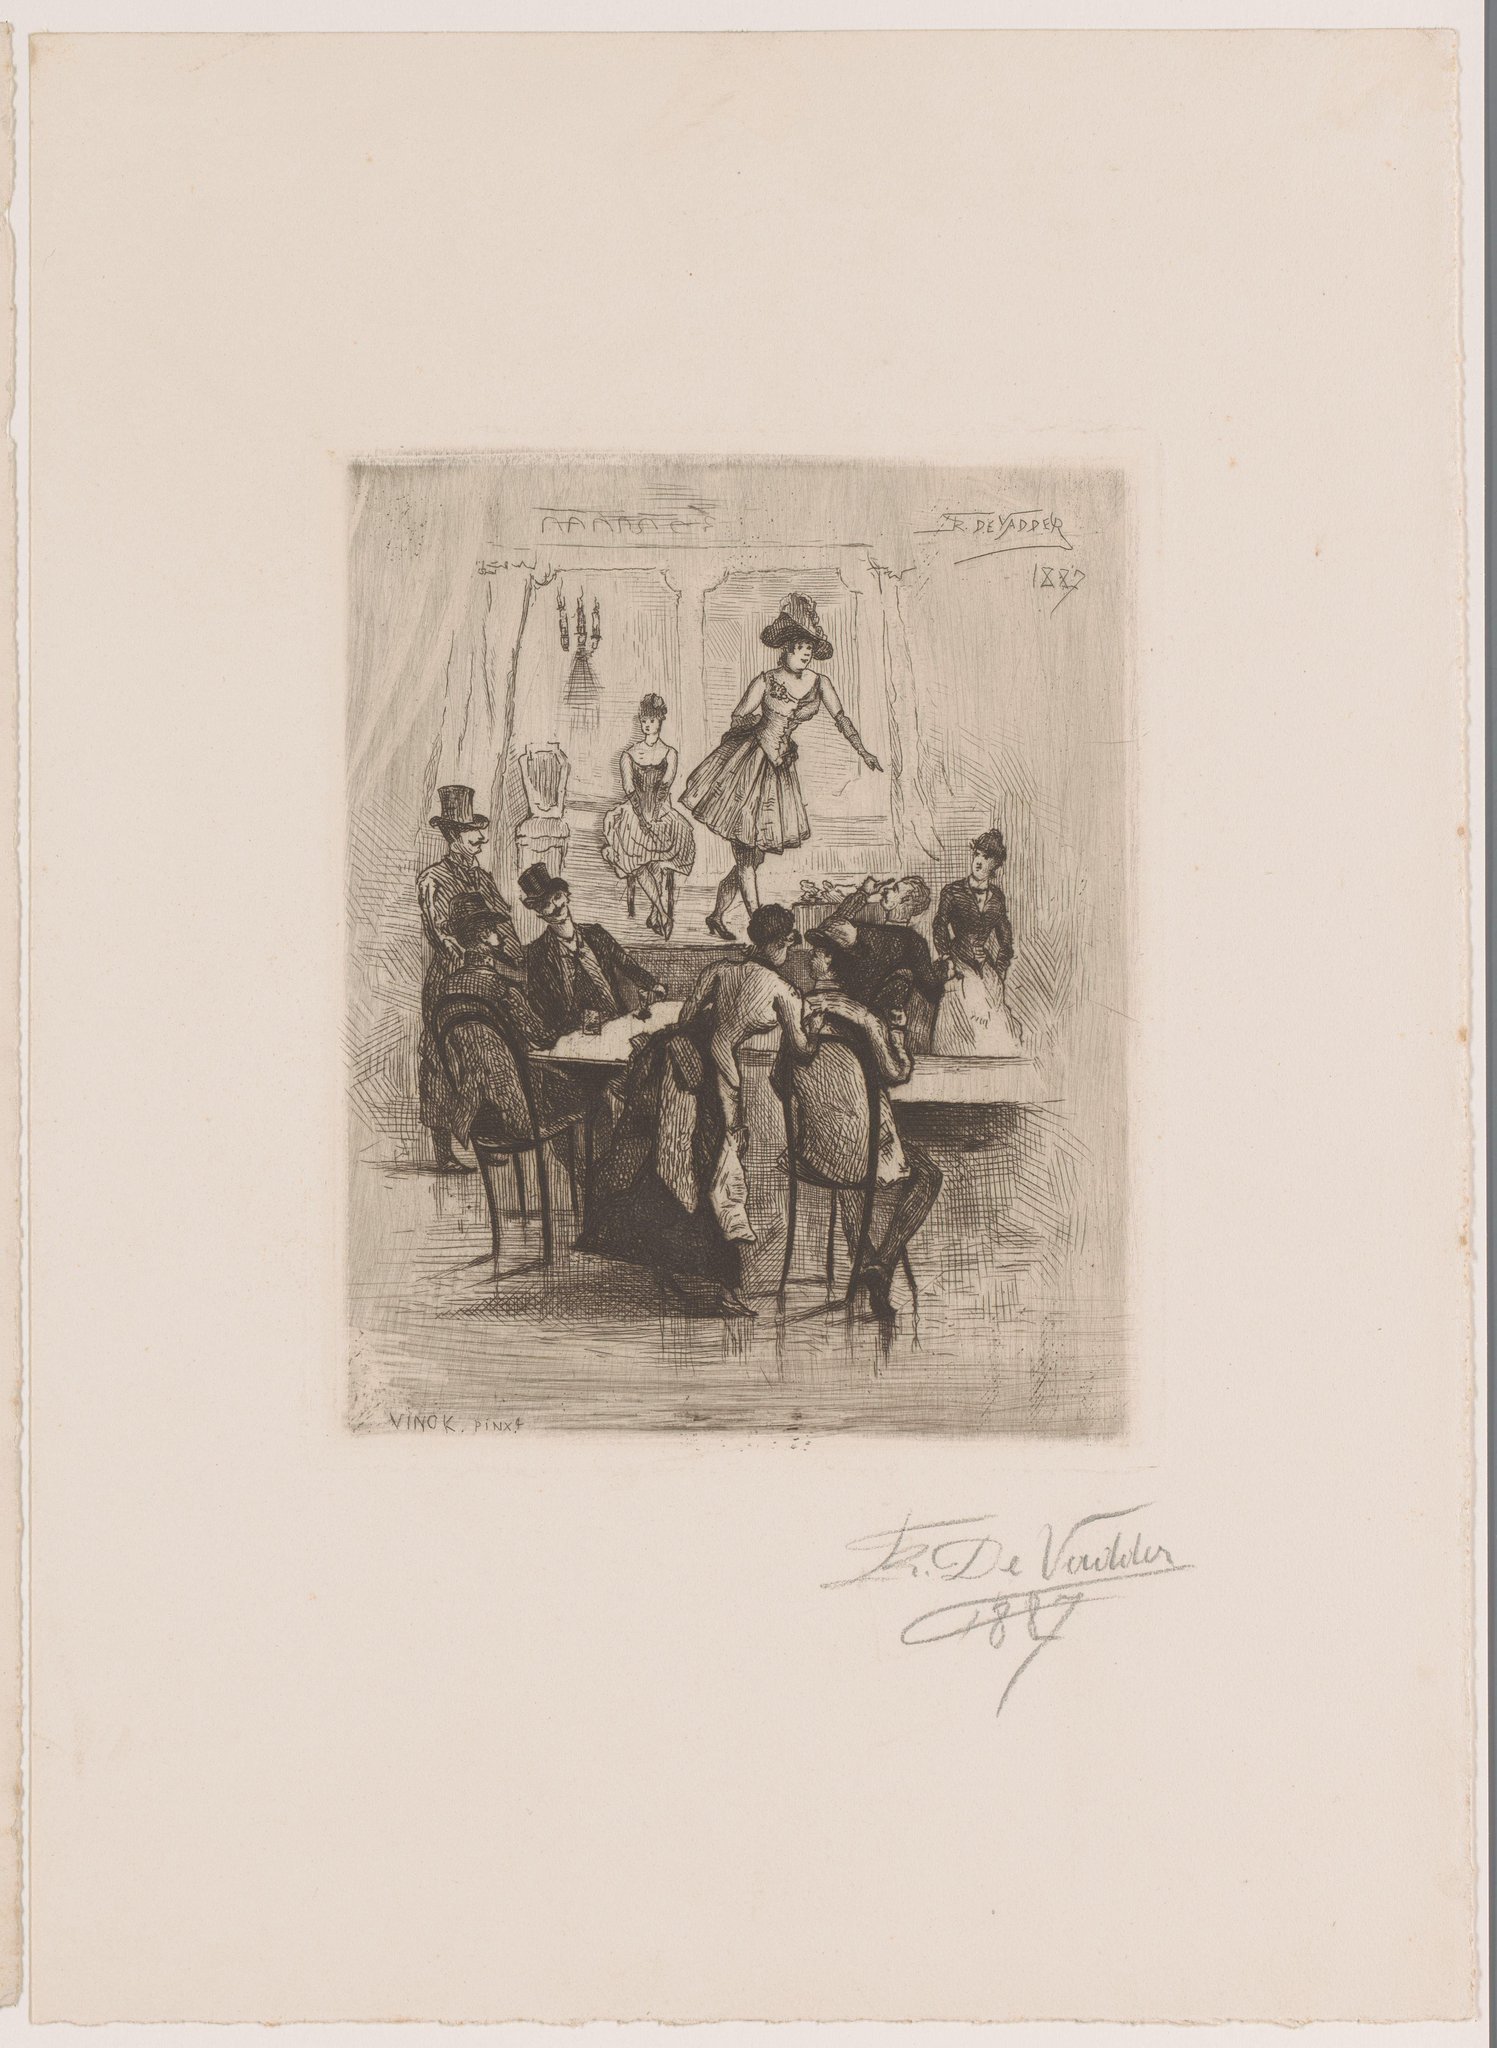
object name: print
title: Café Chantant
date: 1887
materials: paper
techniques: etching, intaglio, retroussage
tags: theatre, theatrical performance, vocal music, singing, indoor recreation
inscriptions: mark: ‘Vin[c]k pinxt.’, collector's mark: Lugt 2228